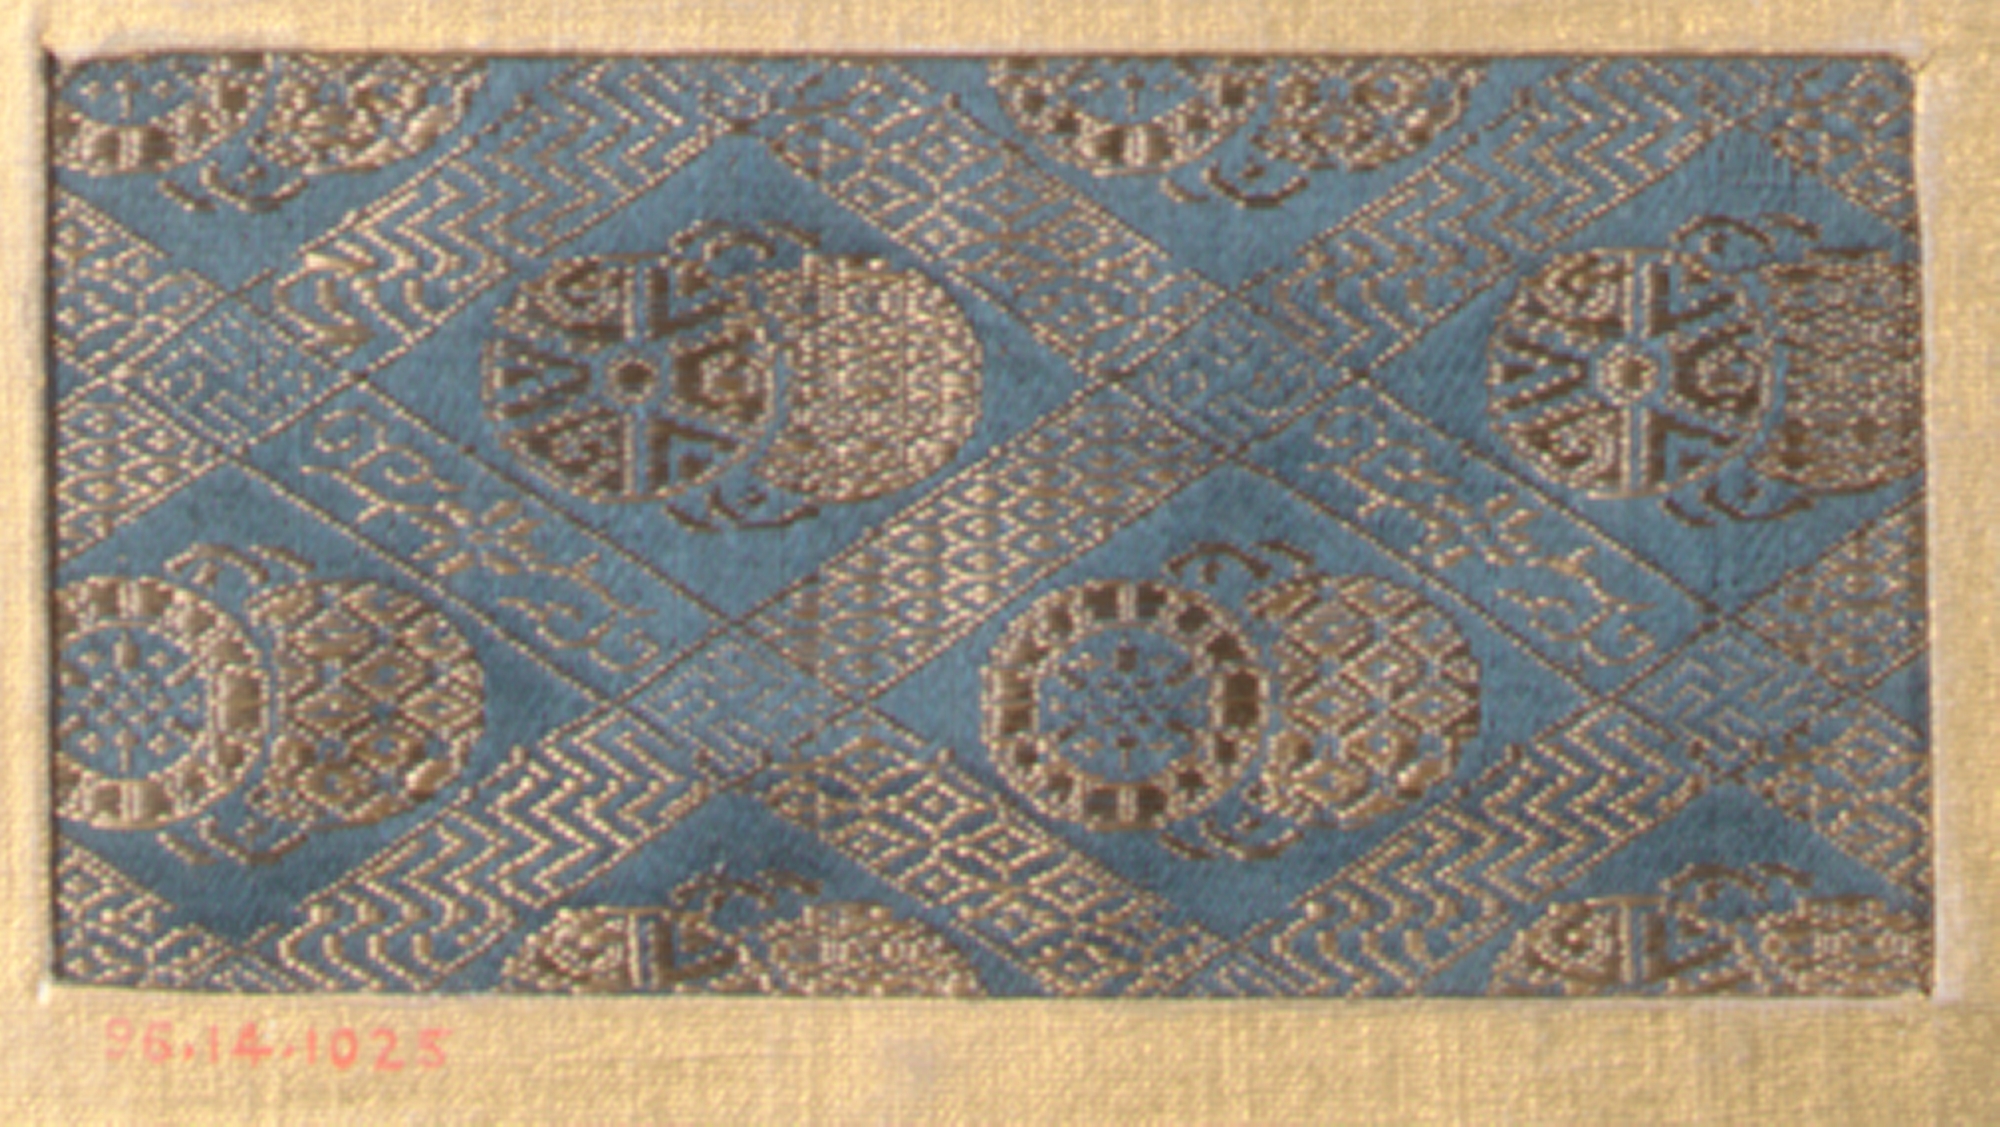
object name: piece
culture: japanese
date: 1701-1900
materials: silk